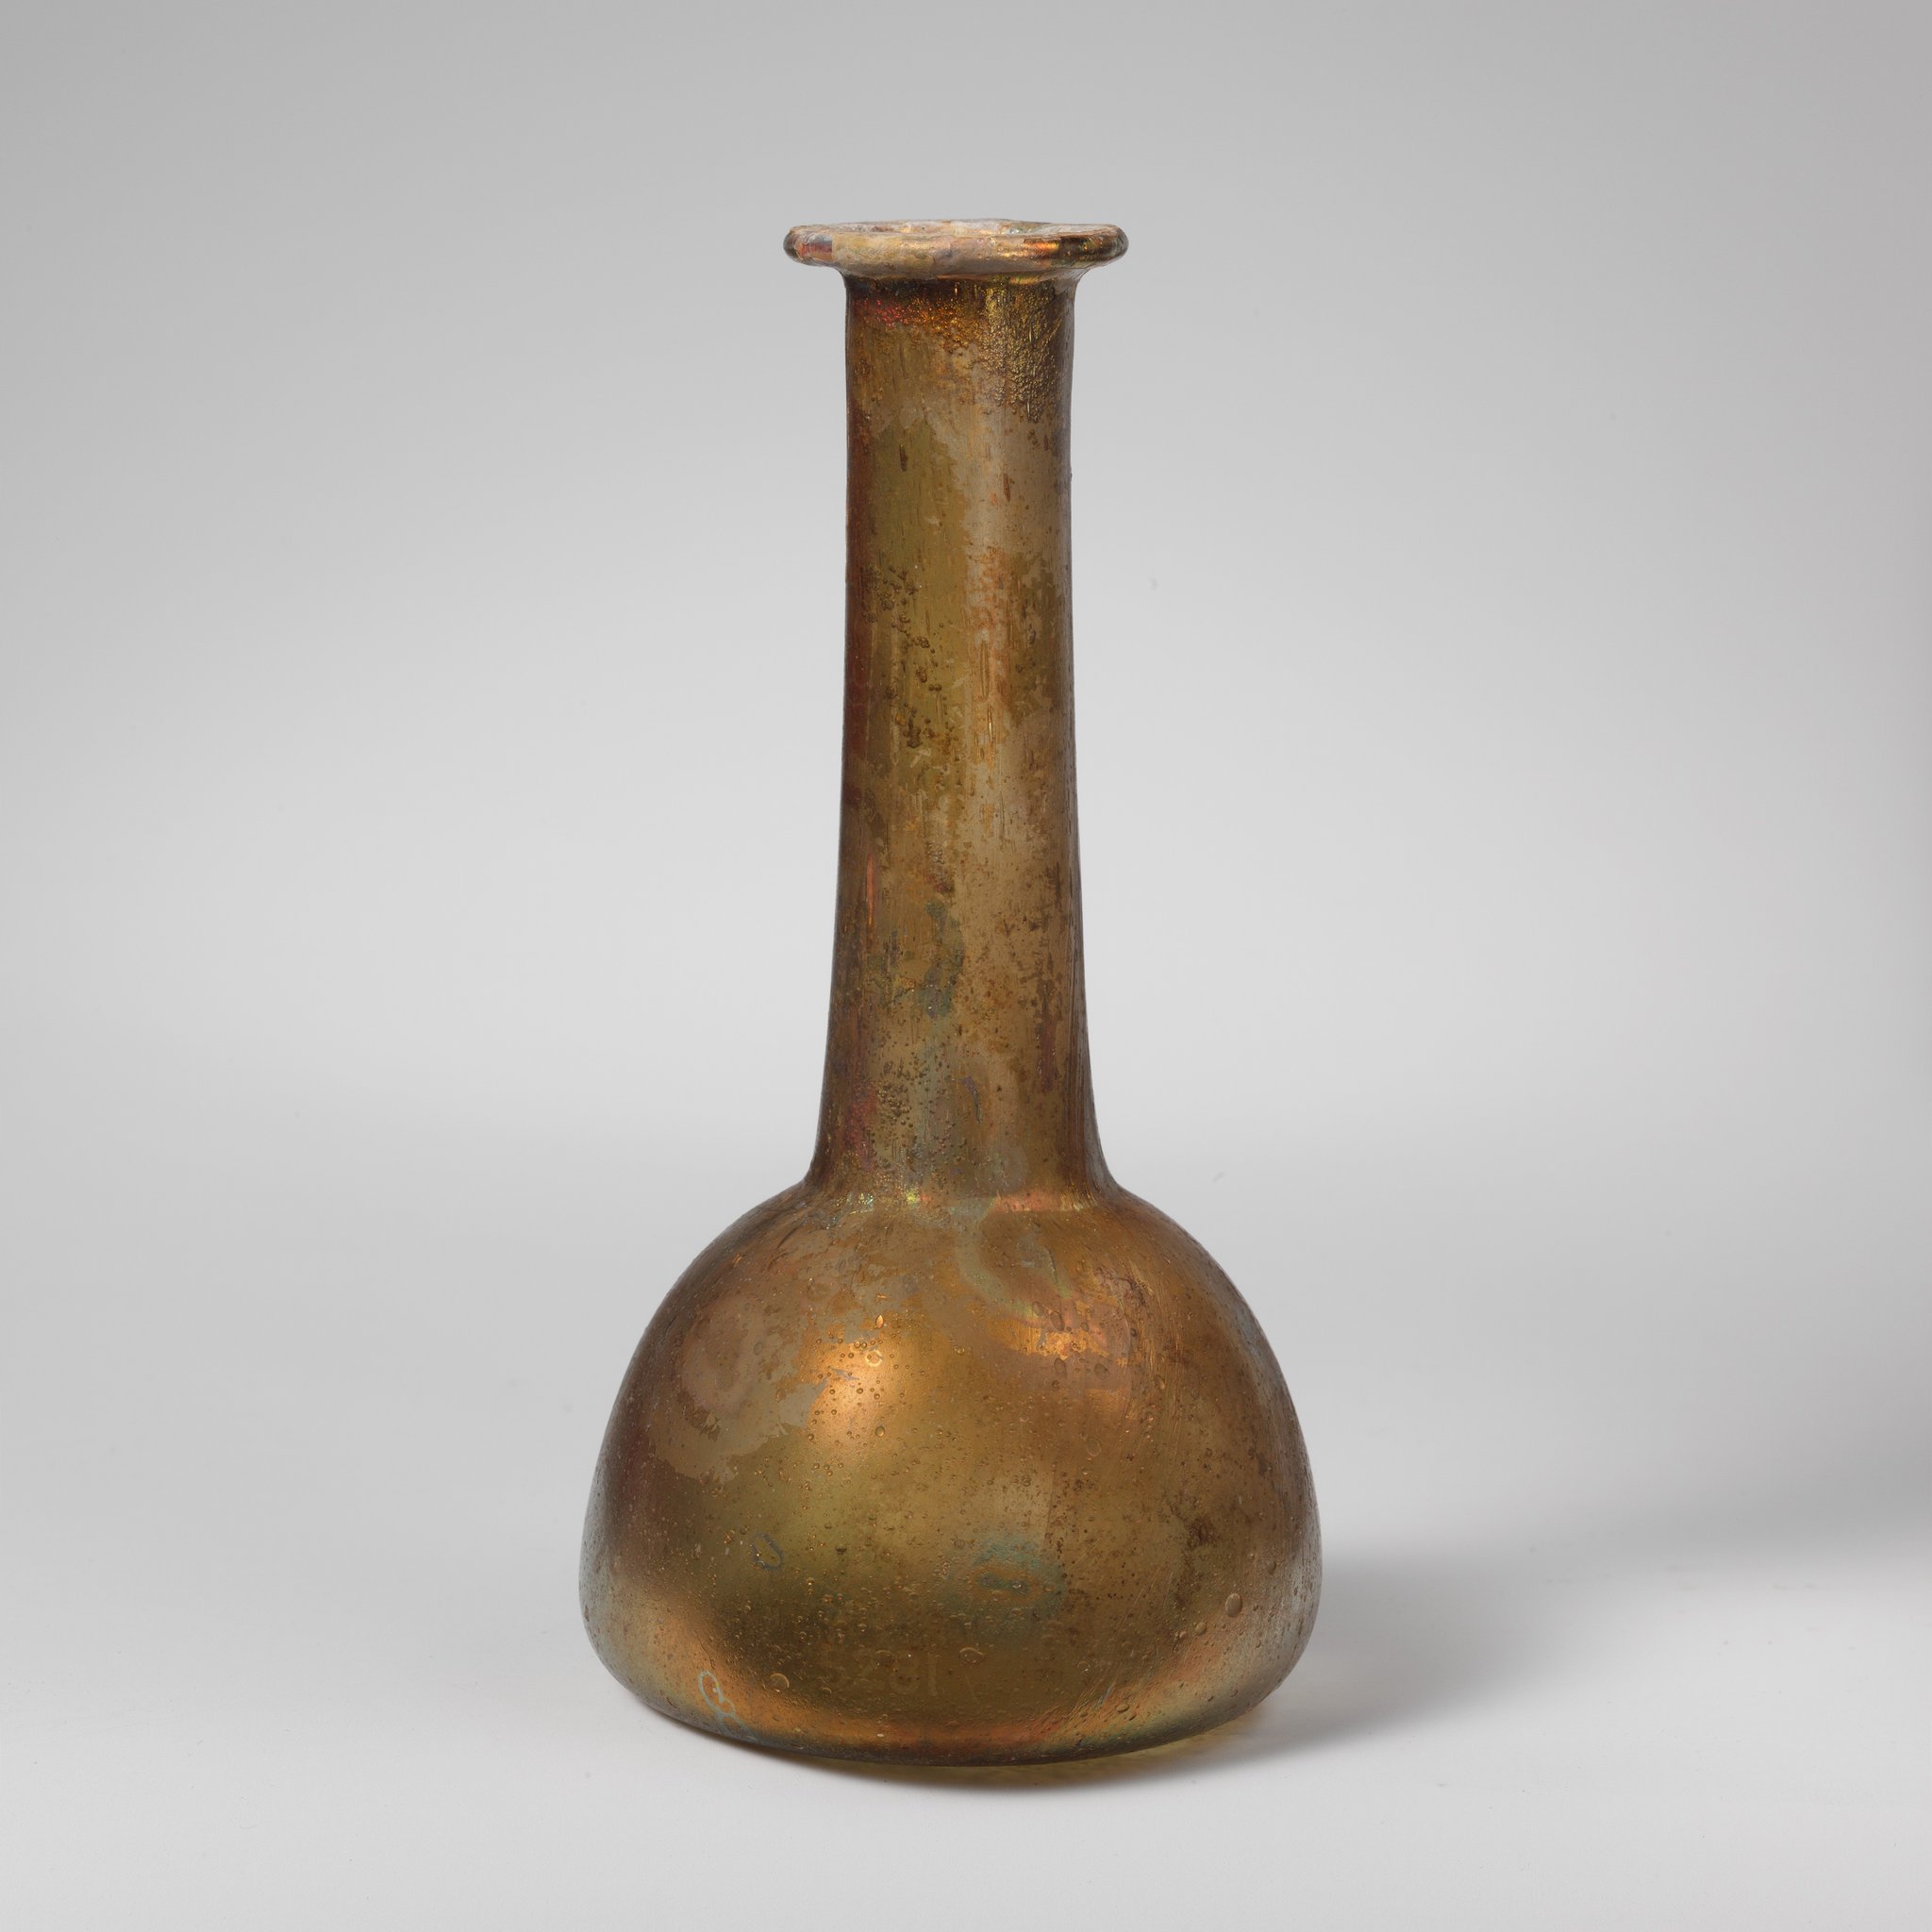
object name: perfume bottle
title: Glass perfume bottle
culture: roman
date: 101-300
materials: glass